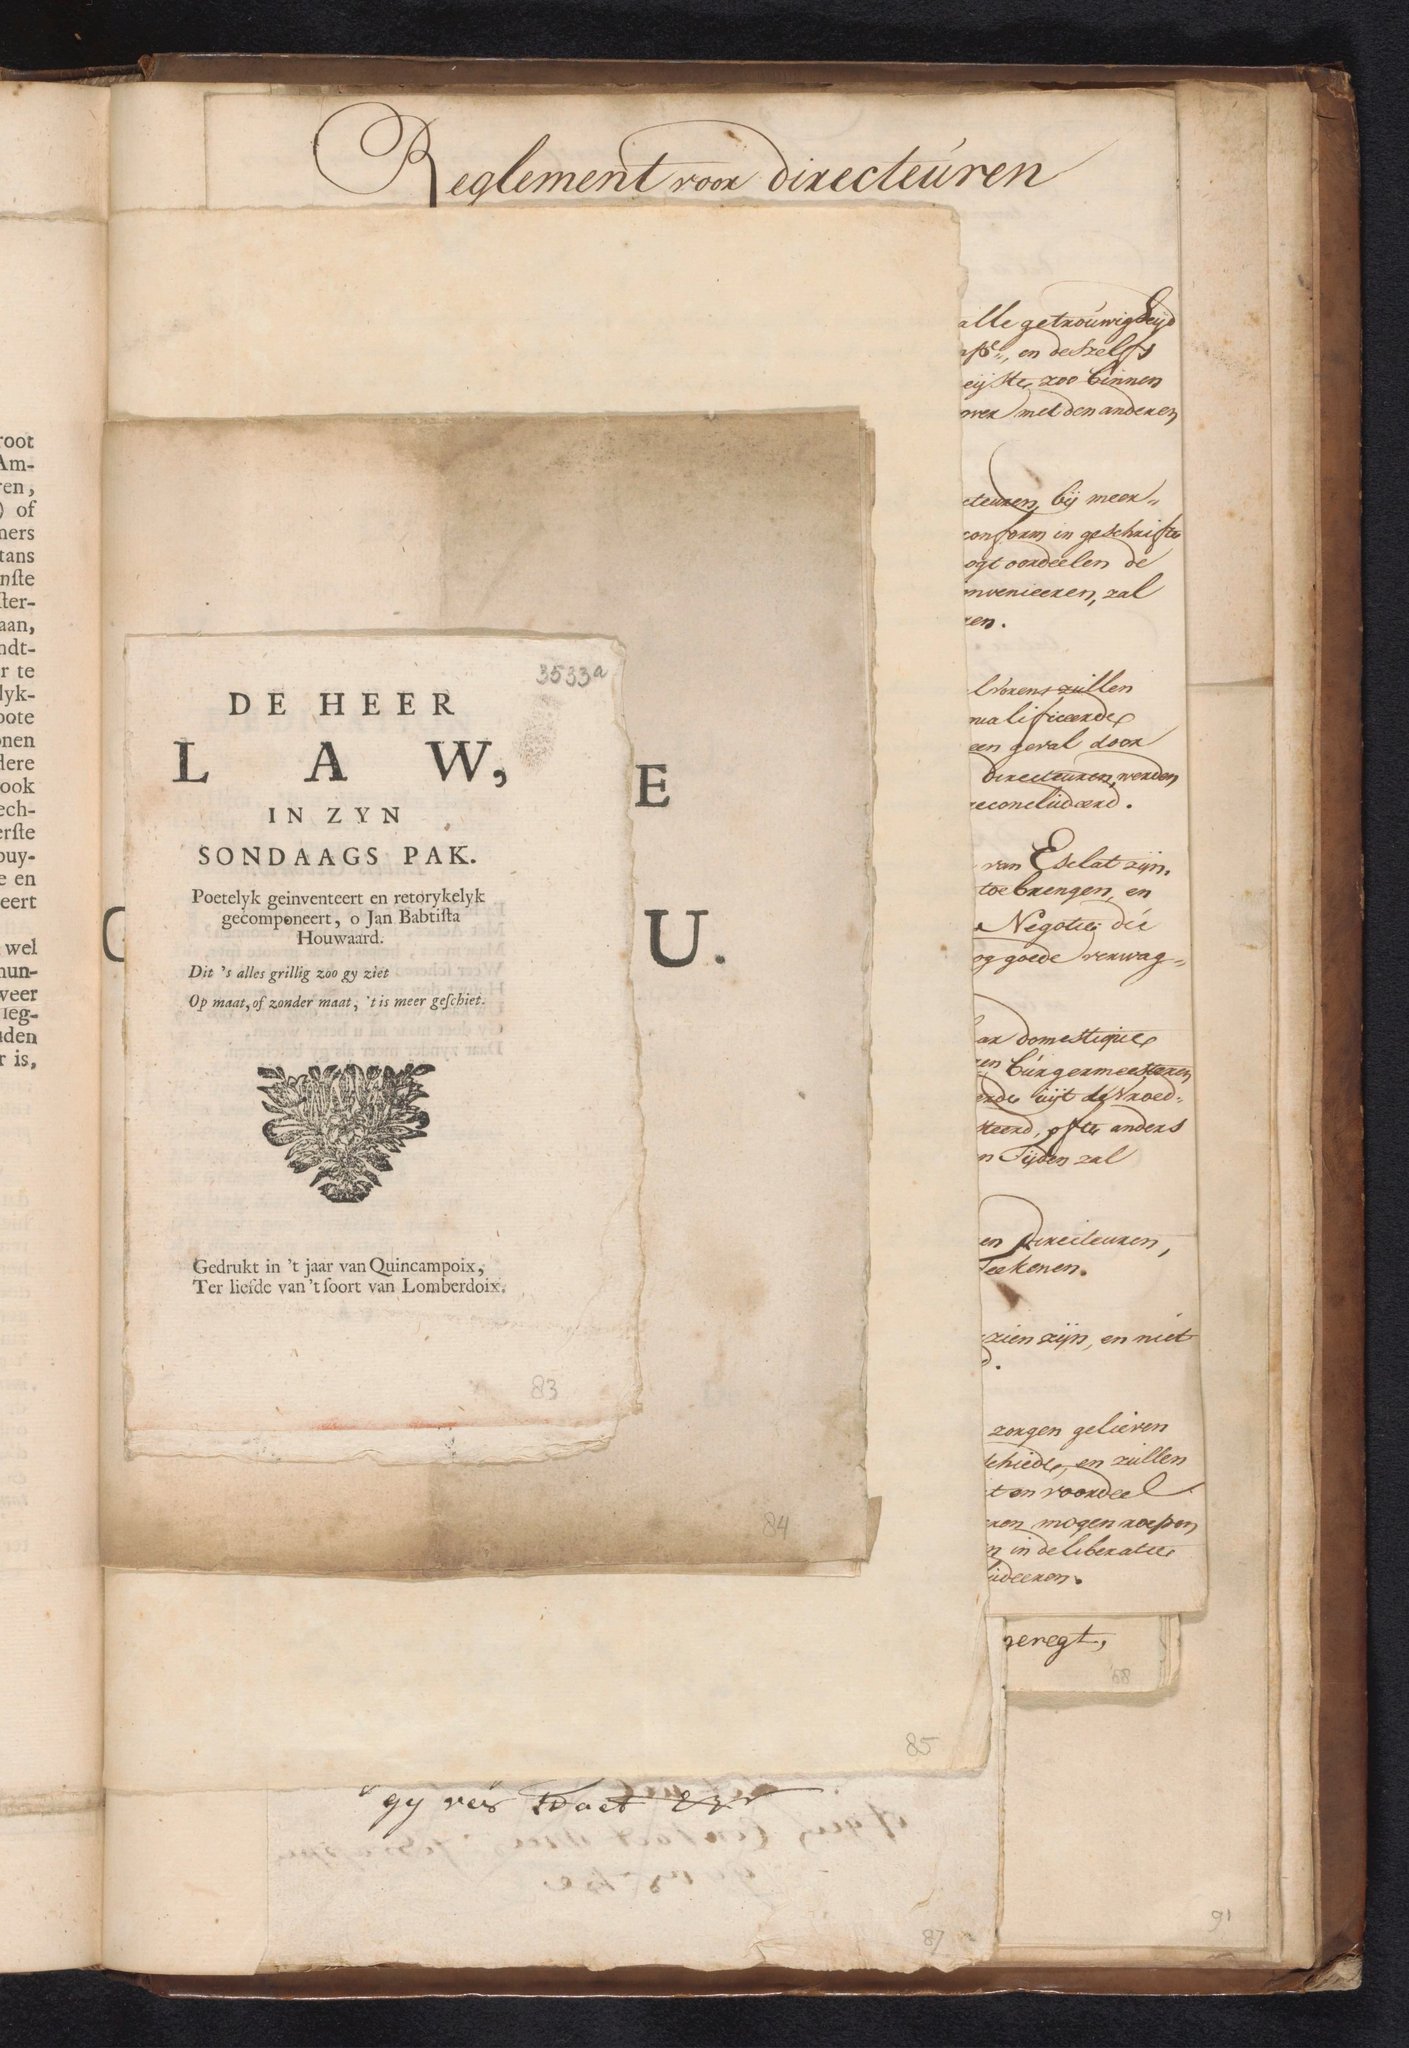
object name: pamphlet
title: Het Groote Tafereel der Dwaasheid (extra stukken)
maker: Anonymous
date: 1720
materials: paper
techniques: letterpress printing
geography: northern netherlands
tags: econoom, john law, windhandel van 1720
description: Pamflet van acht bladzijden met verschillende verzen waarin John Law bespot wordt, 1720. Behoort tot de groep van extra stukken meegebonden in de gebonden eerste uitgave (304 B 11) van Het Tafereel der Dwaasheid met spotprenten op de Windhandel of Actiehandel van 1720.